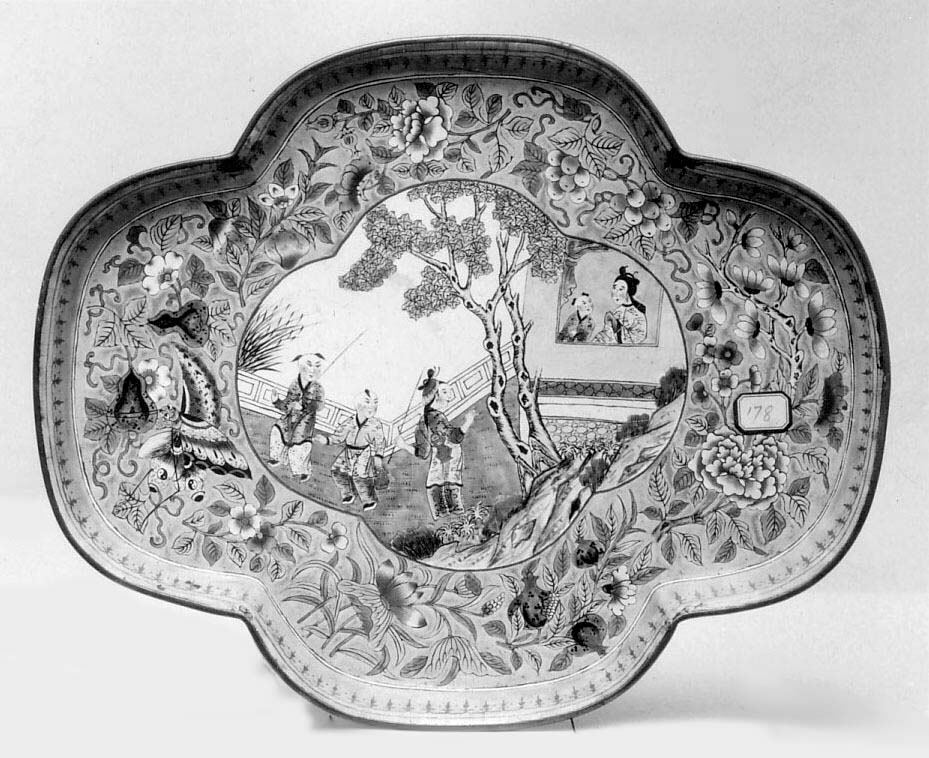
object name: tray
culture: chinese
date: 1801-1900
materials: enamel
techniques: painting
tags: human figures,trees